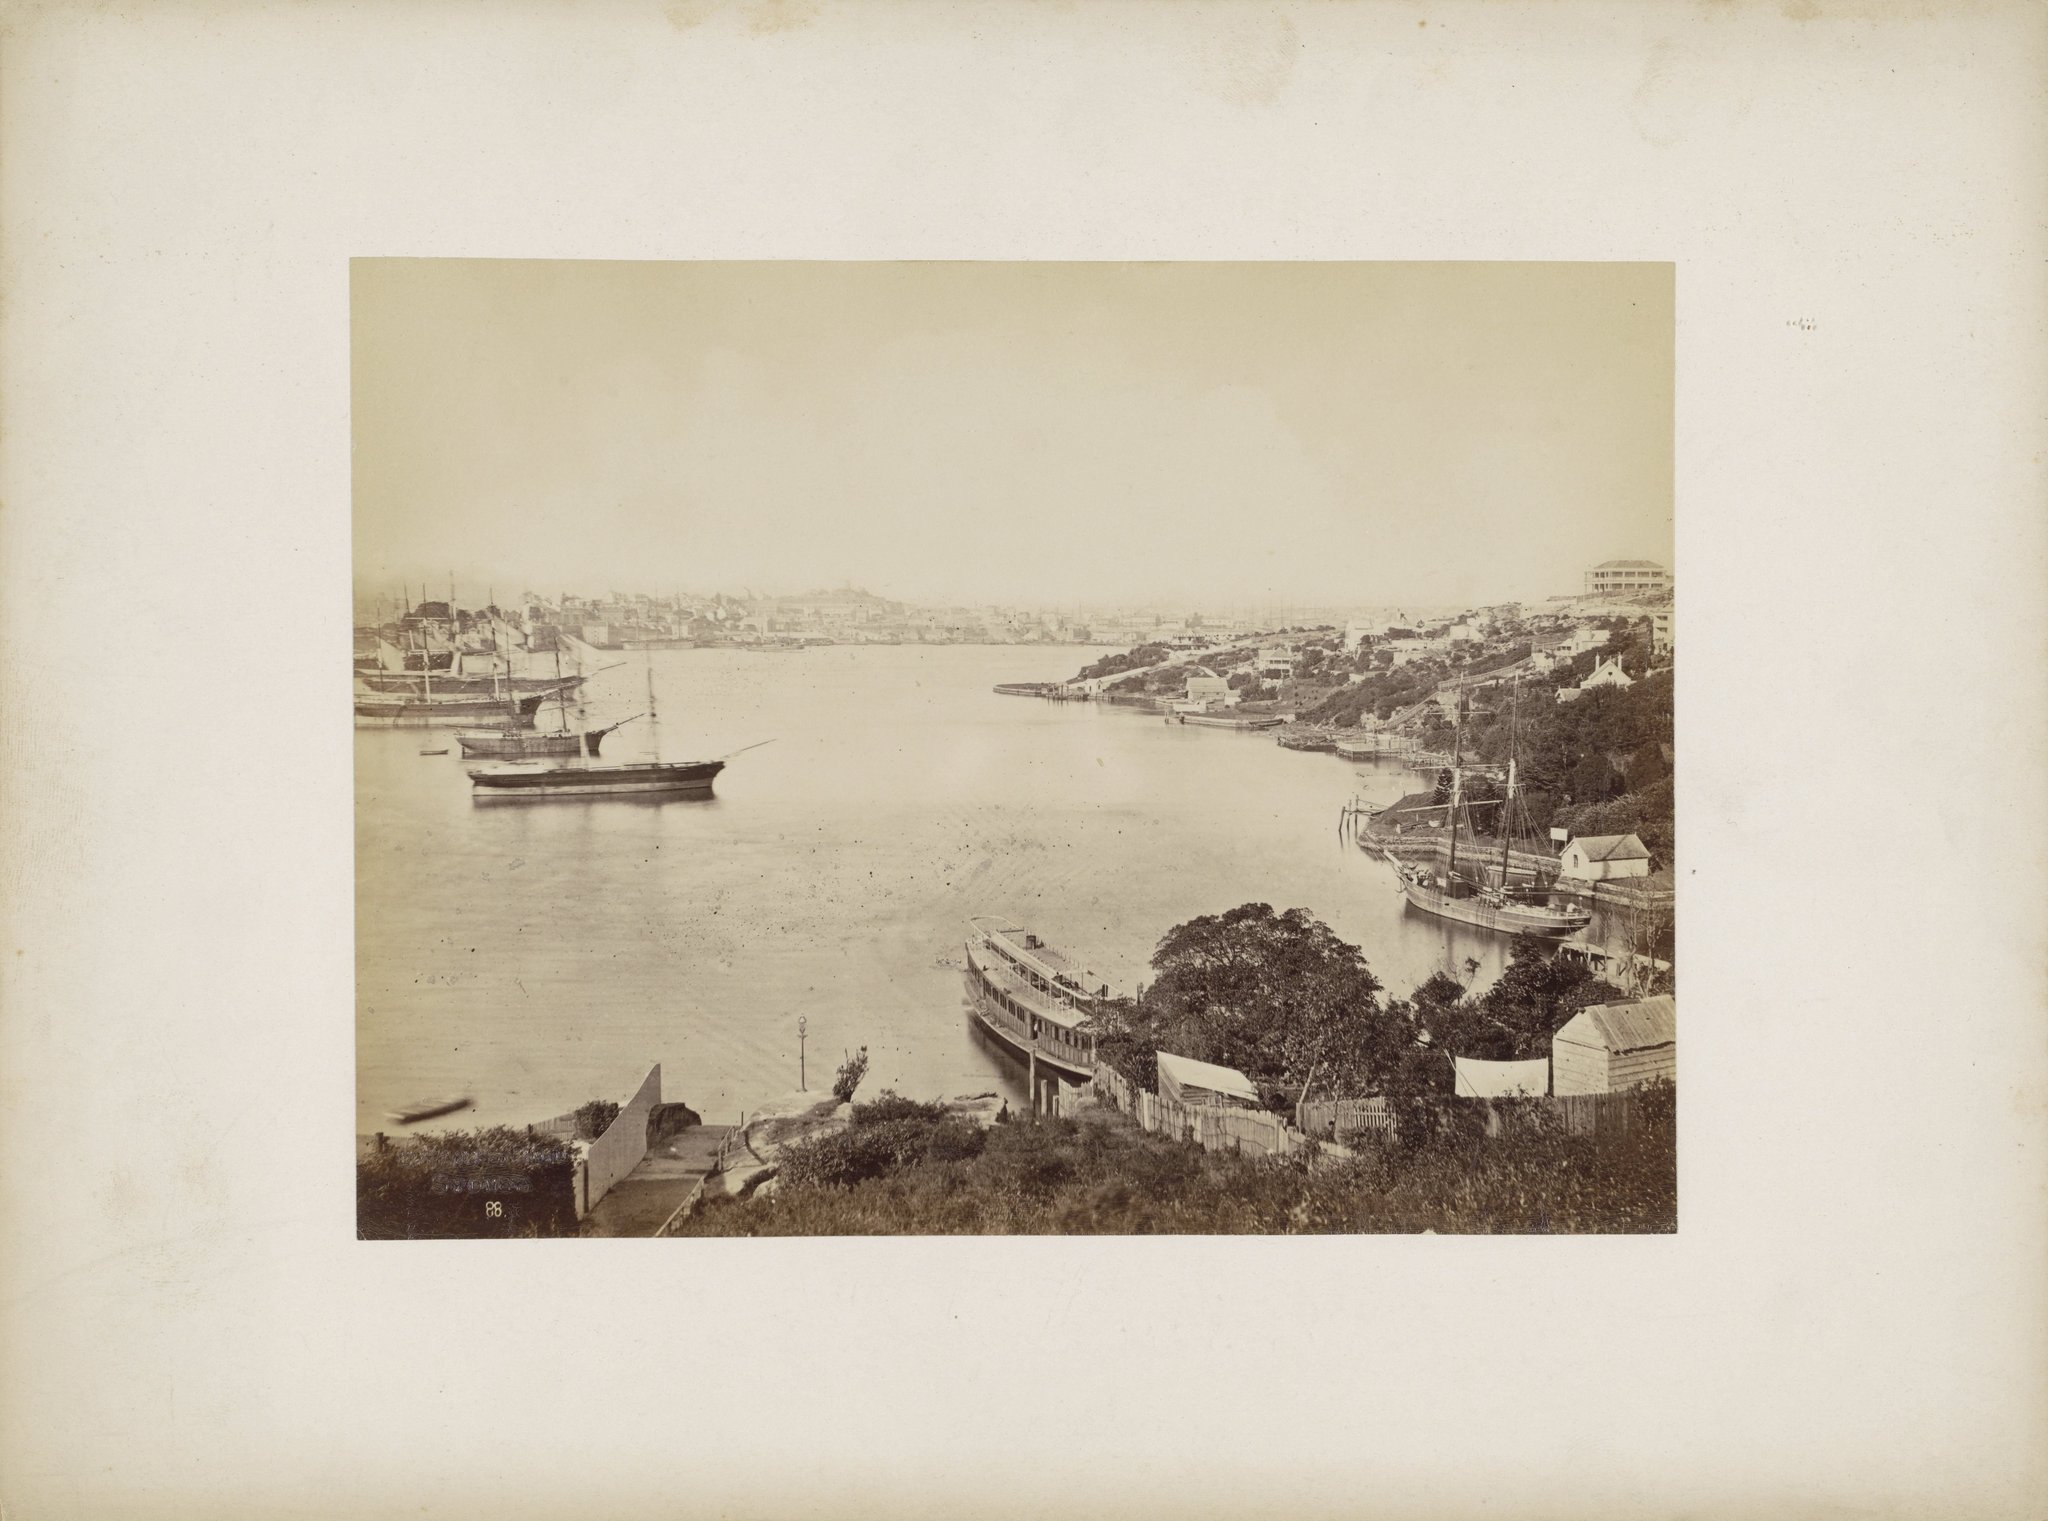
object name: photograph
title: Gezicht op een haven, vermoedelijk in Sydney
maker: charles bayliss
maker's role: fotograaf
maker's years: 1850-1897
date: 1890-1910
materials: cardboard, paper, photographic support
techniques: albumen print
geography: sydney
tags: harbour (+ view ~ vehicle, ship, etc.)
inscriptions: check stamp: ‘C. Bayliss Photo Sydney’, negative number: ‘88’, inscription: ‘uit map met foto's van Sydney gekocht Waterlooplein Amsterdam 1963 à f 0,10’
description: Onderdeel van Reisalbum met foto's van bezienswaardigheden in Sydney.